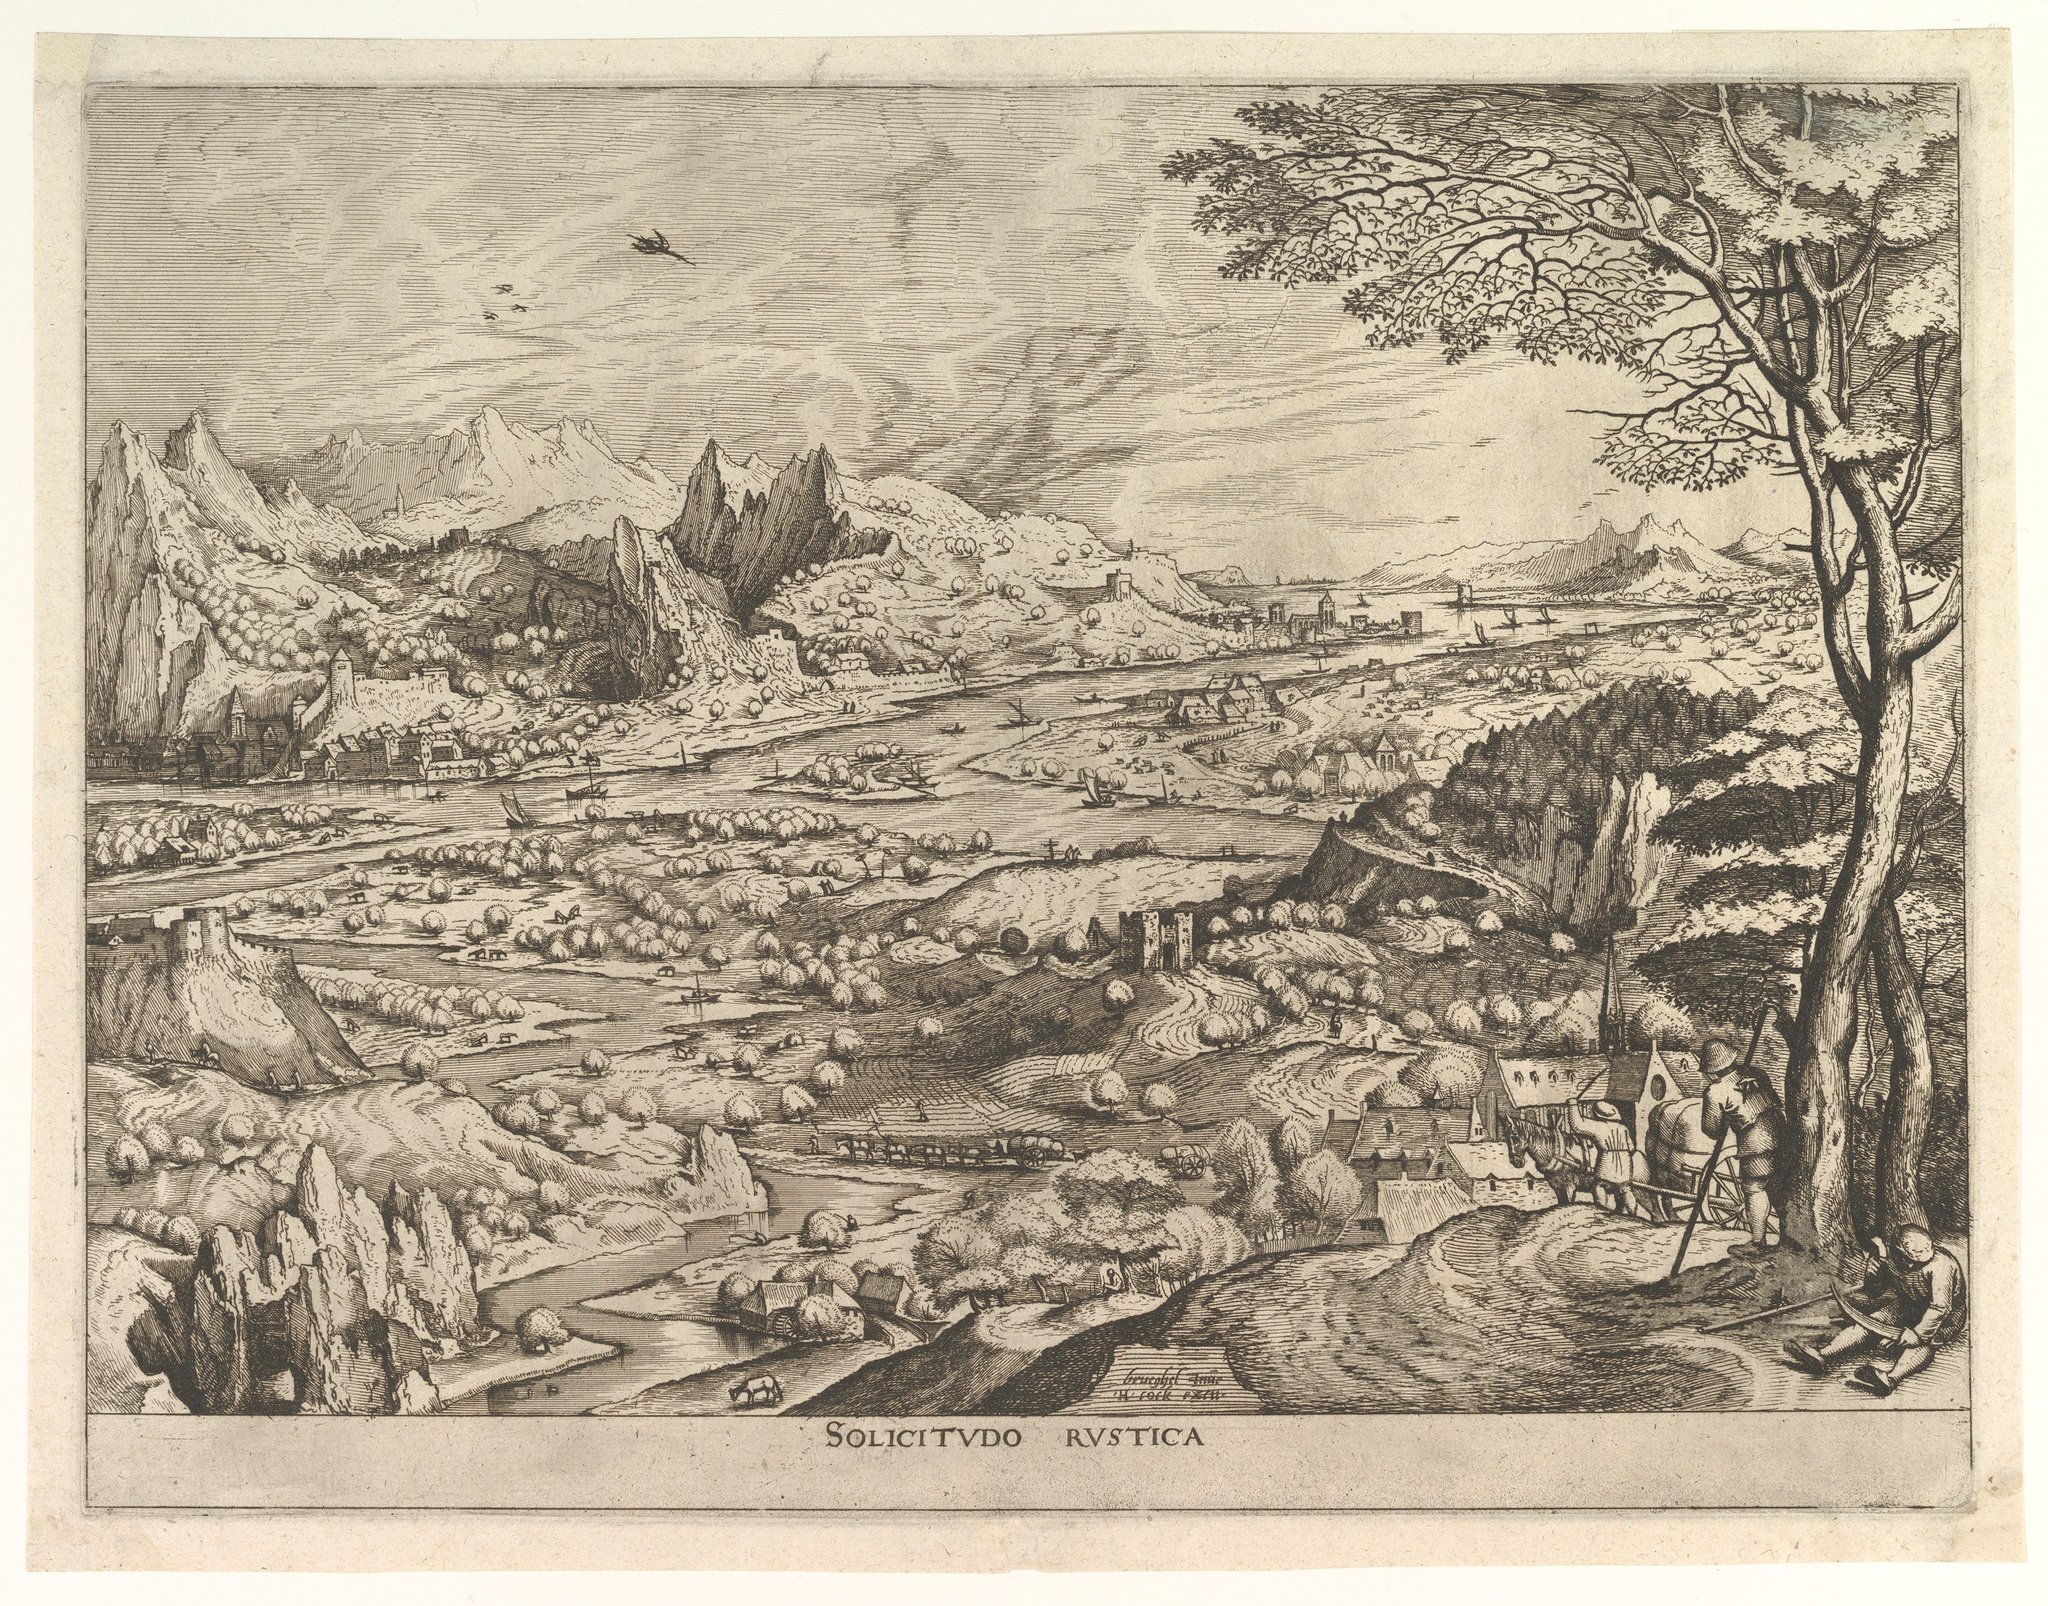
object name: print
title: Rustic Solicitude (Solicitudo rustica), from "The Large Landscapes"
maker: johannes van doetecum i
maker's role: artist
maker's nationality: netherlandish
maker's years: 1528-1605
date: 1555-1556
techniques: engraving, etching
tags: rivers,mountains,landscapes